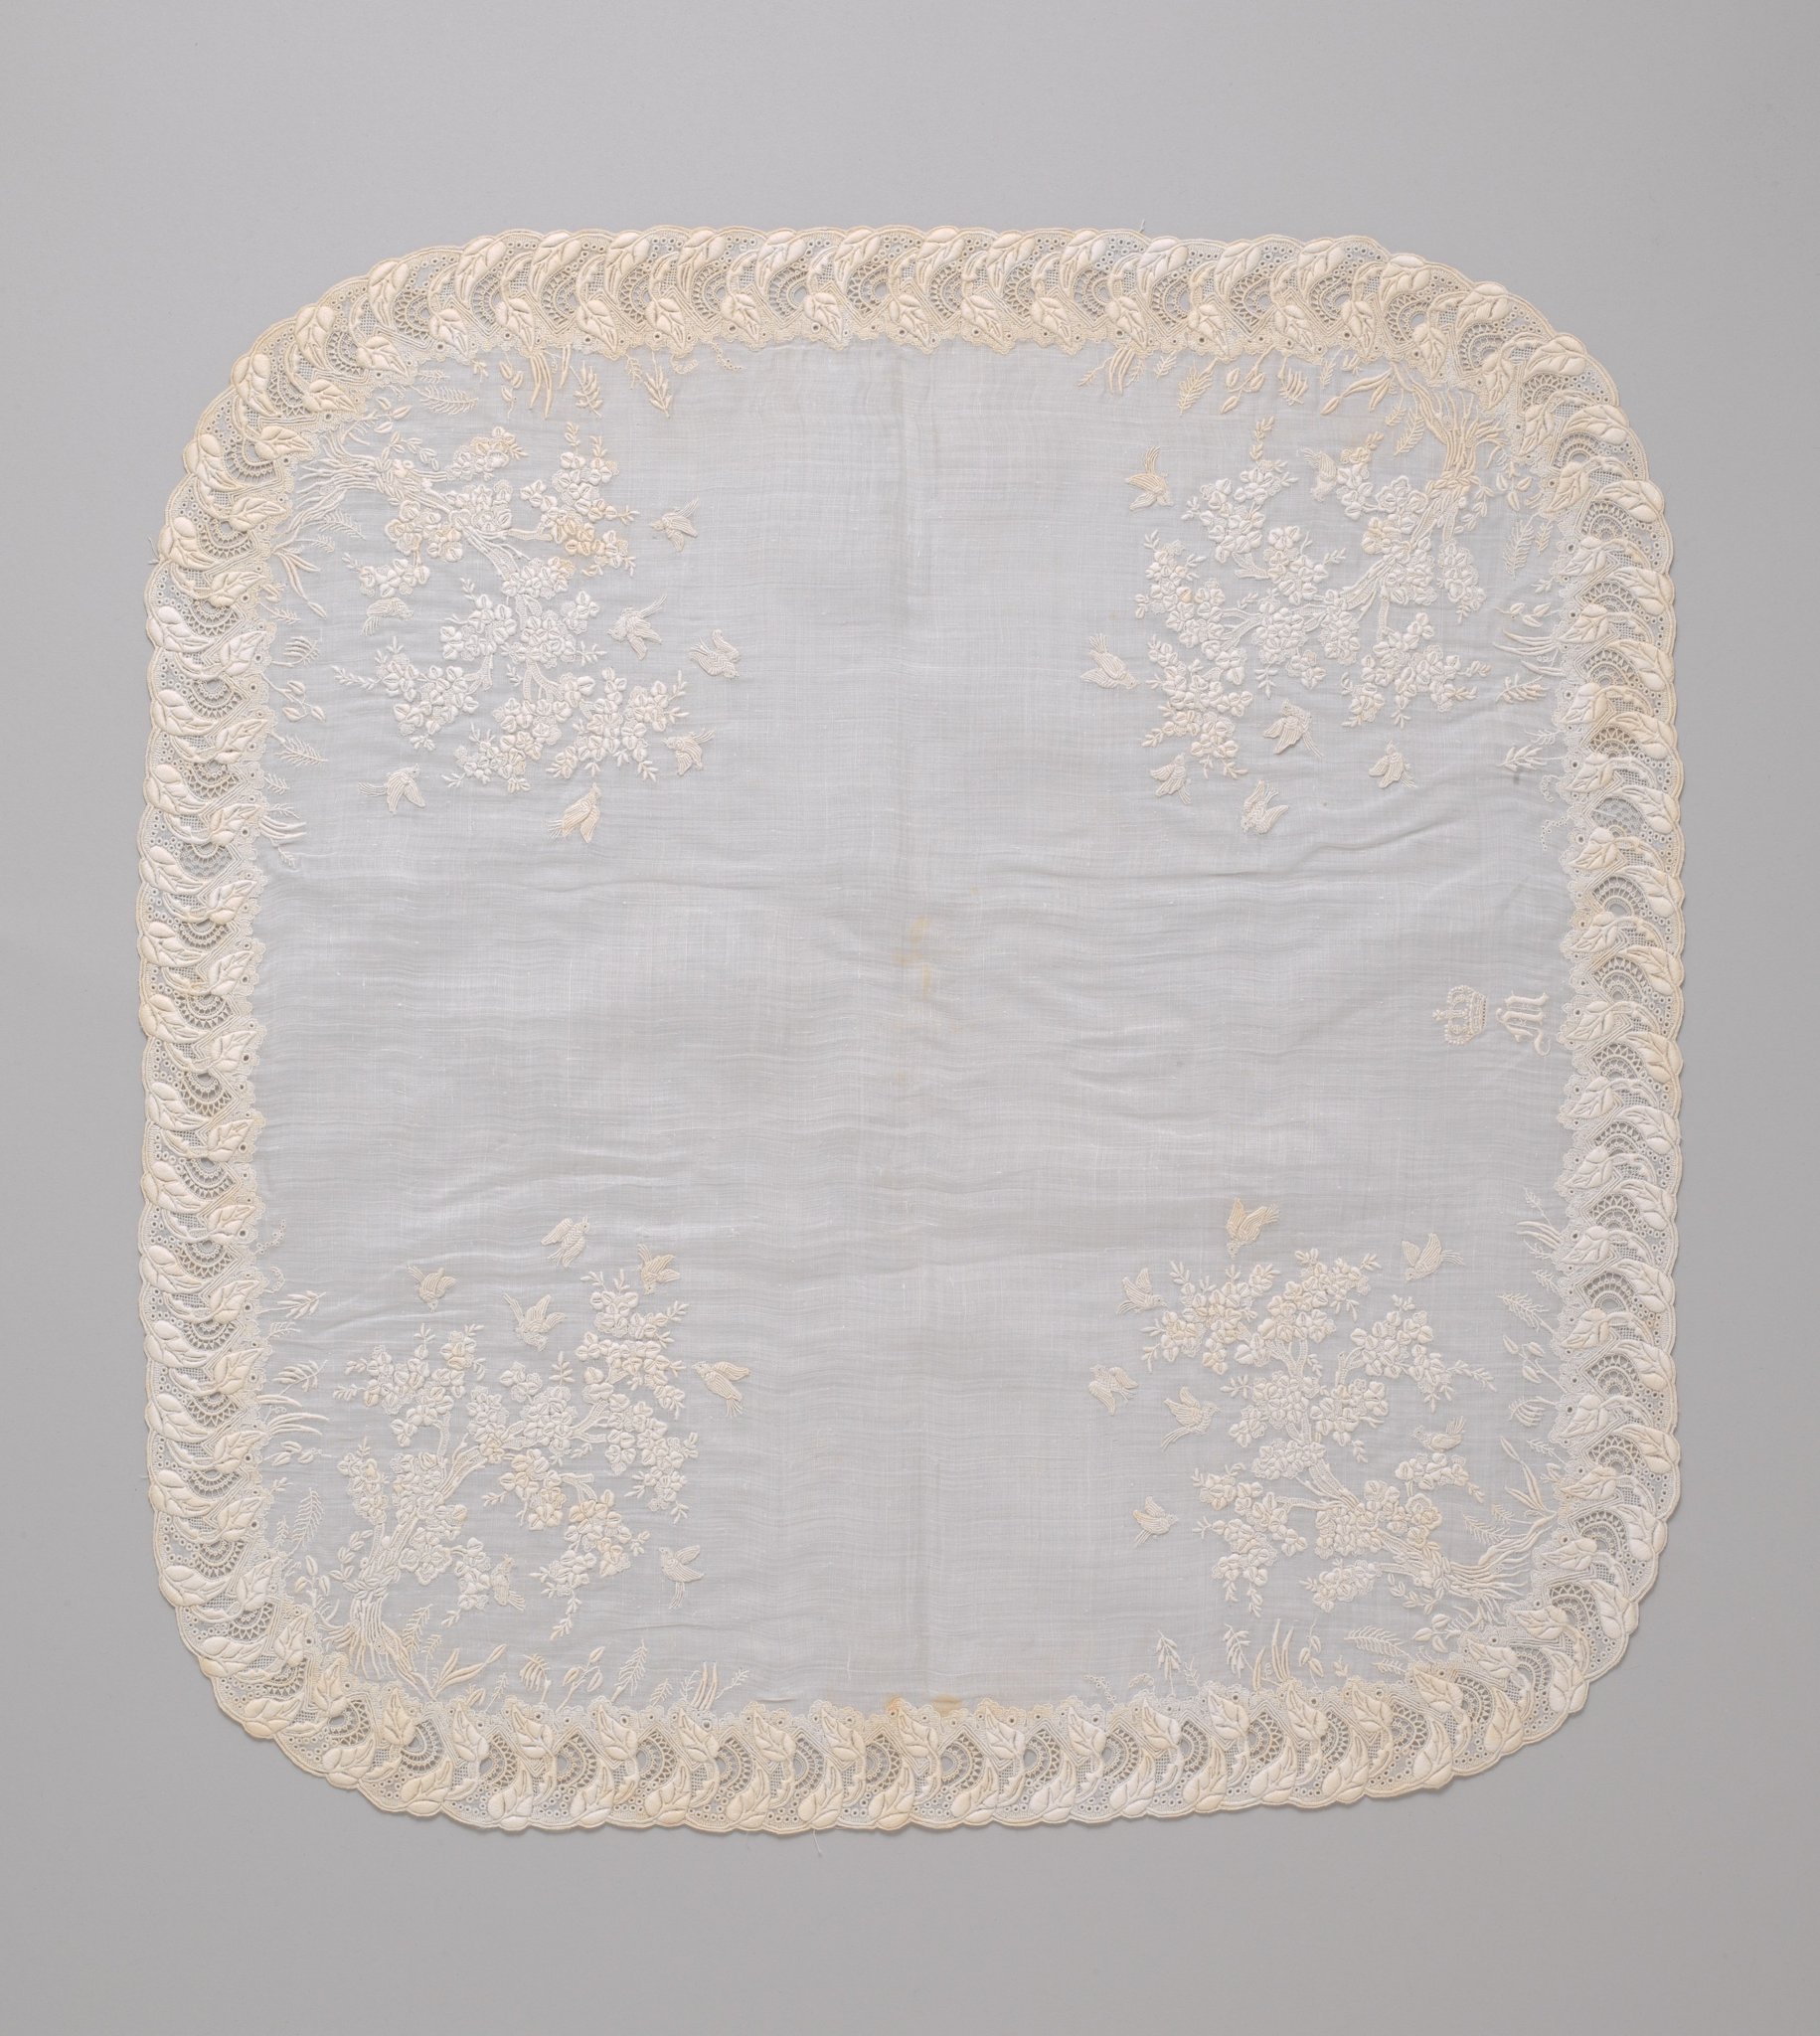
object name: handkerchief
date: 1840-1880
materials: linen, silk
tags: trees